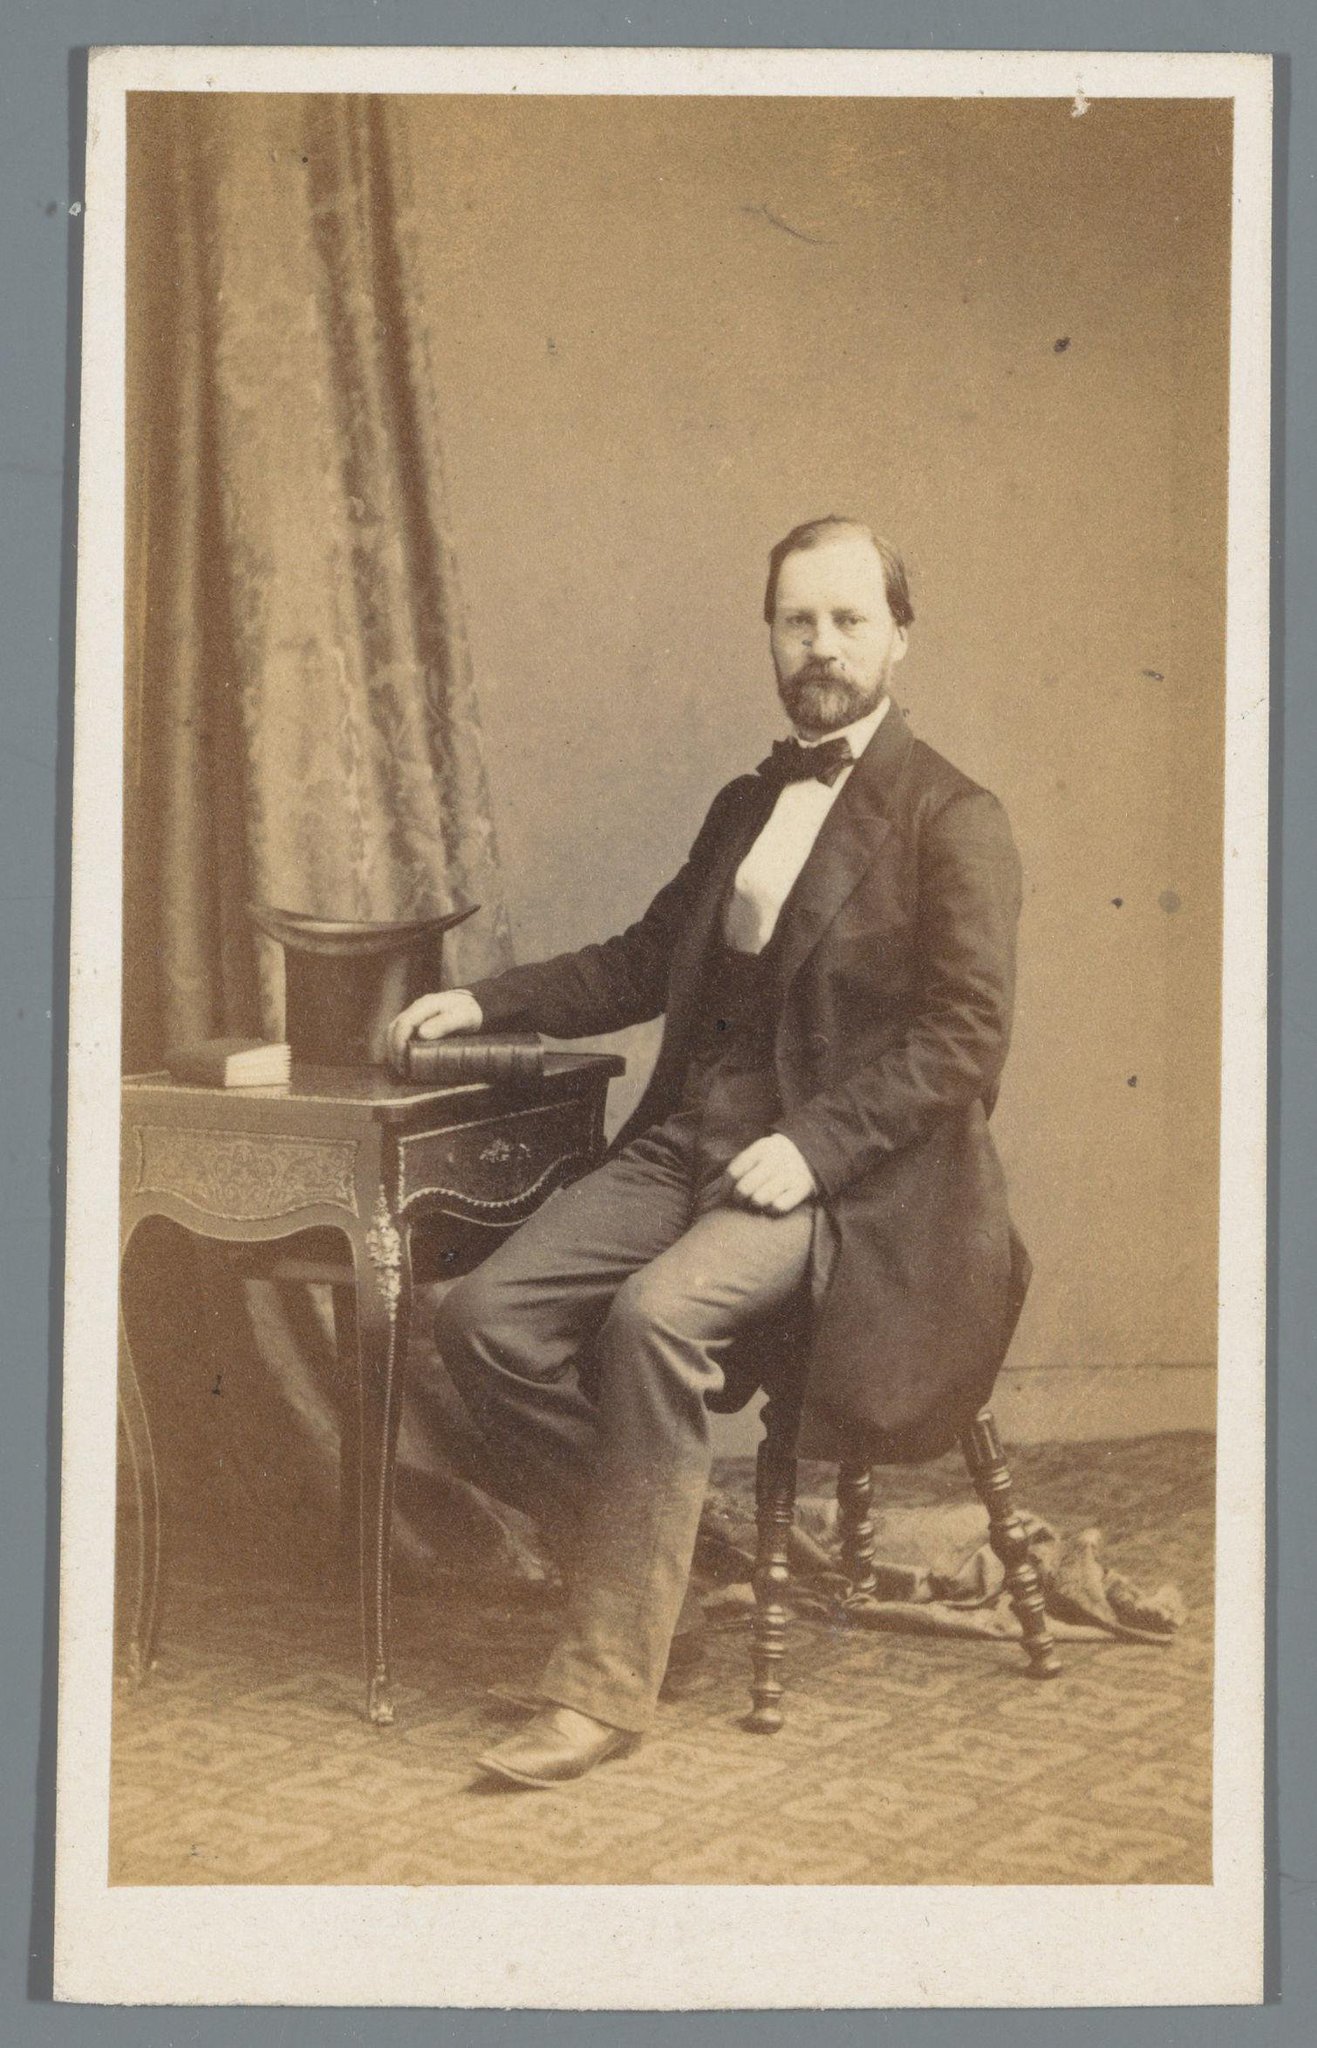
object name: photograph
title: Portret van een onbekende man, zittend aan tafel met een boek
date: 1852-1863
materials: cardboard, paper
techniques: albumen print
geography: paris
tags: adult man, historical persons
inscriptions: inscription: ‘Bisson Frères/ Paris’